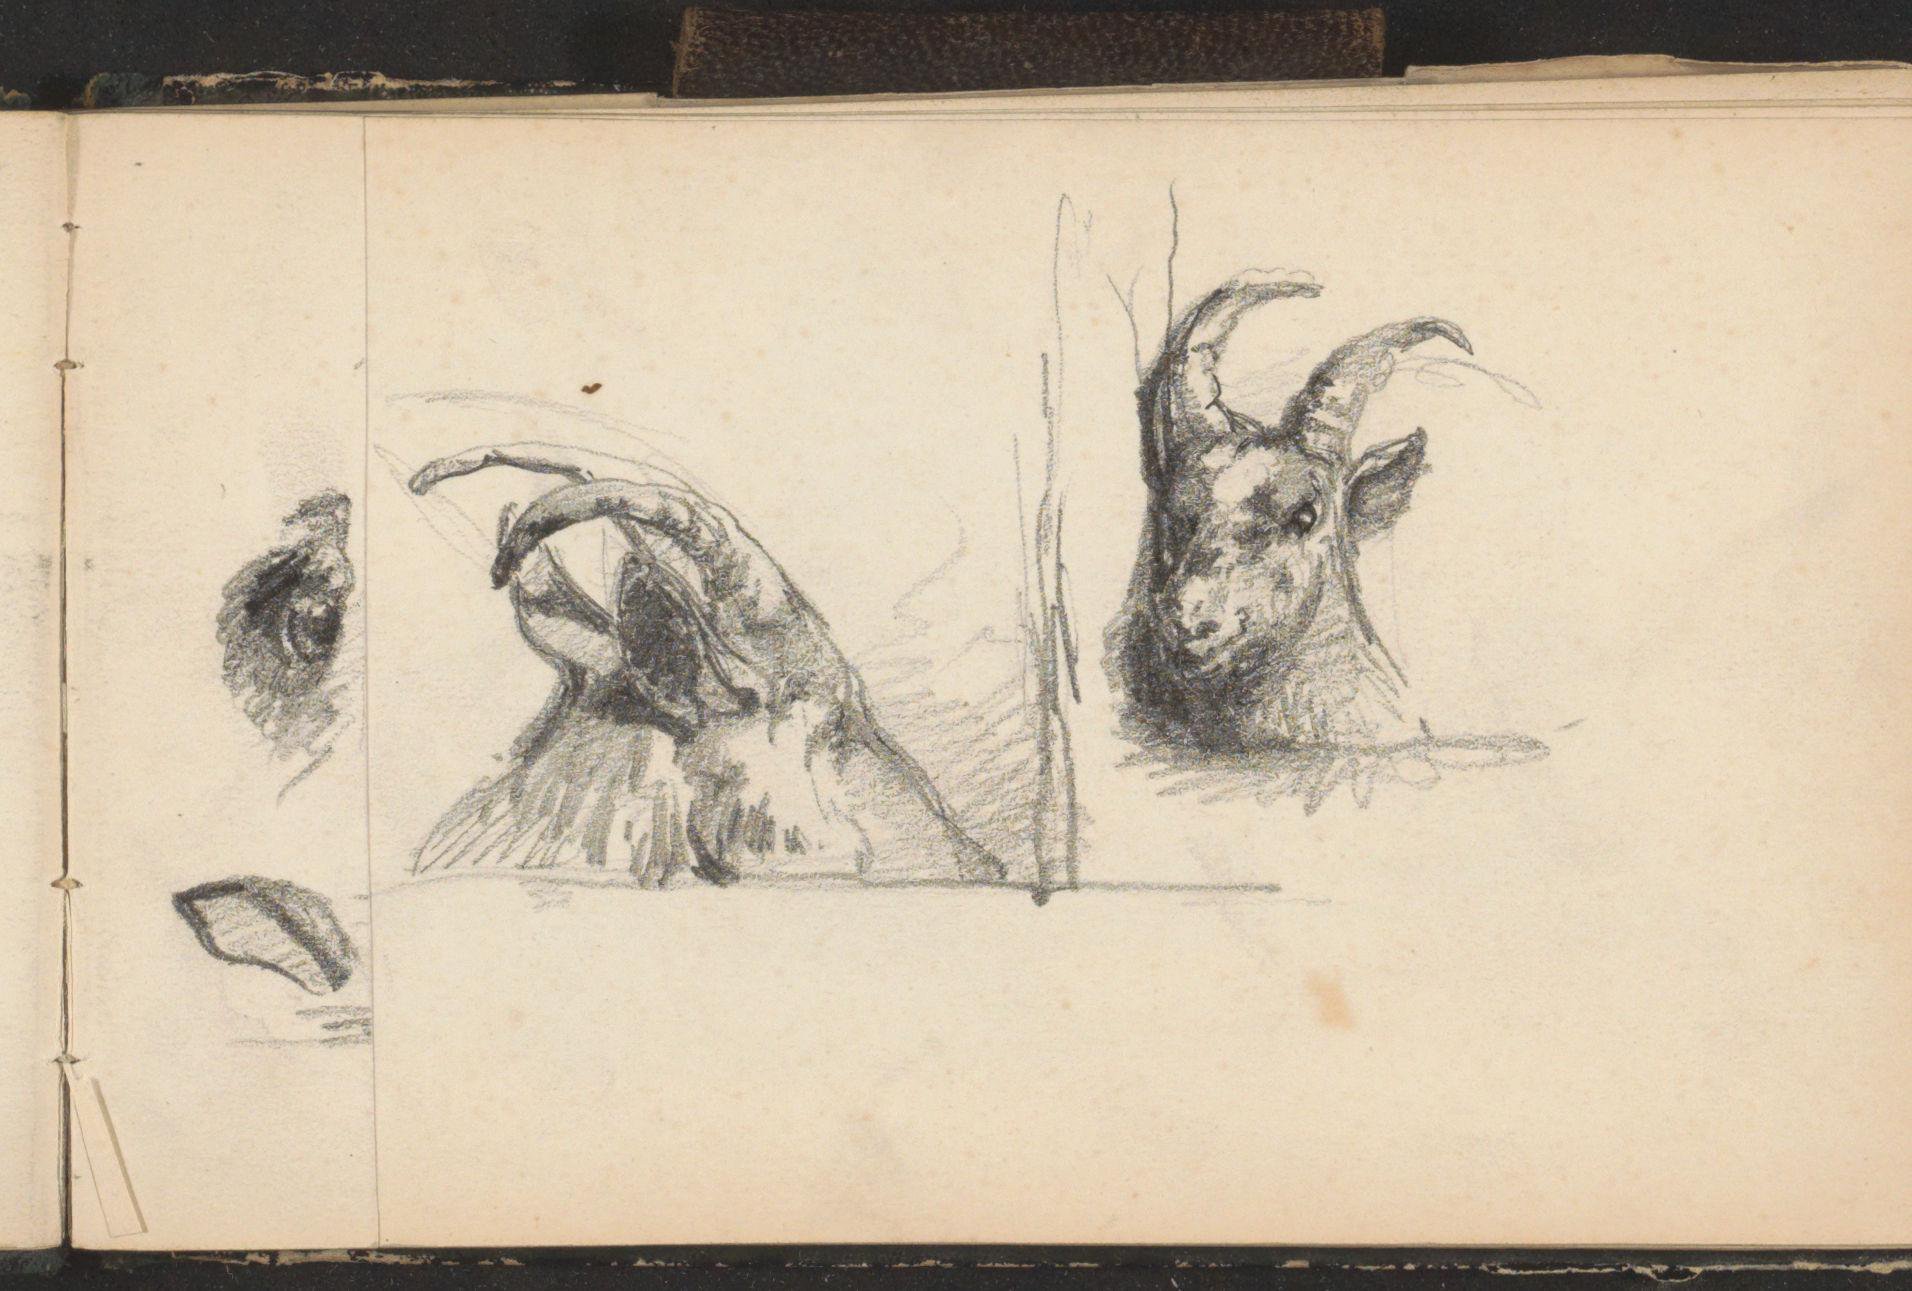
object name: sketchbook leaf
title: Oog van een dier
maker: maria vos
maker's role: draughtsman, painter, print maker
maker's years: 1824-1906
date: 1834-1906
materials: paper, pencil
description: Tevens een studie, mogelijk van een blad. Blad 8 recto uit een schetsboek met 46 bladen.